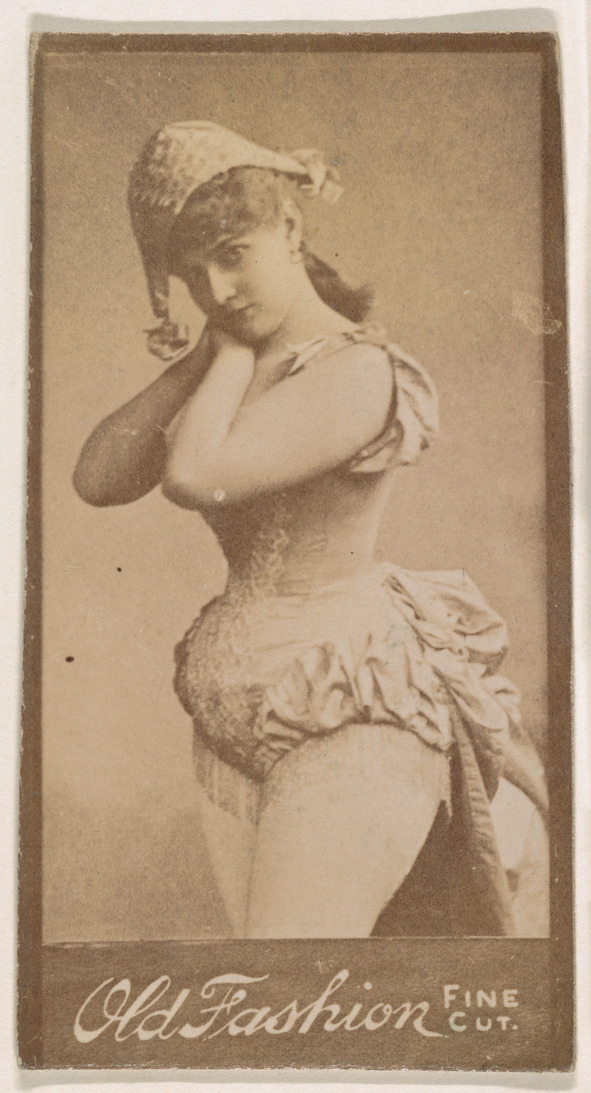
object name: photograph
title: Actress resting face on hands, from the Actresses series (N664) promoting Old Fashion Fine Cut Tobacco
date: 1888-1890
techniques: albumen silver print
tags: portraits,women,actresses